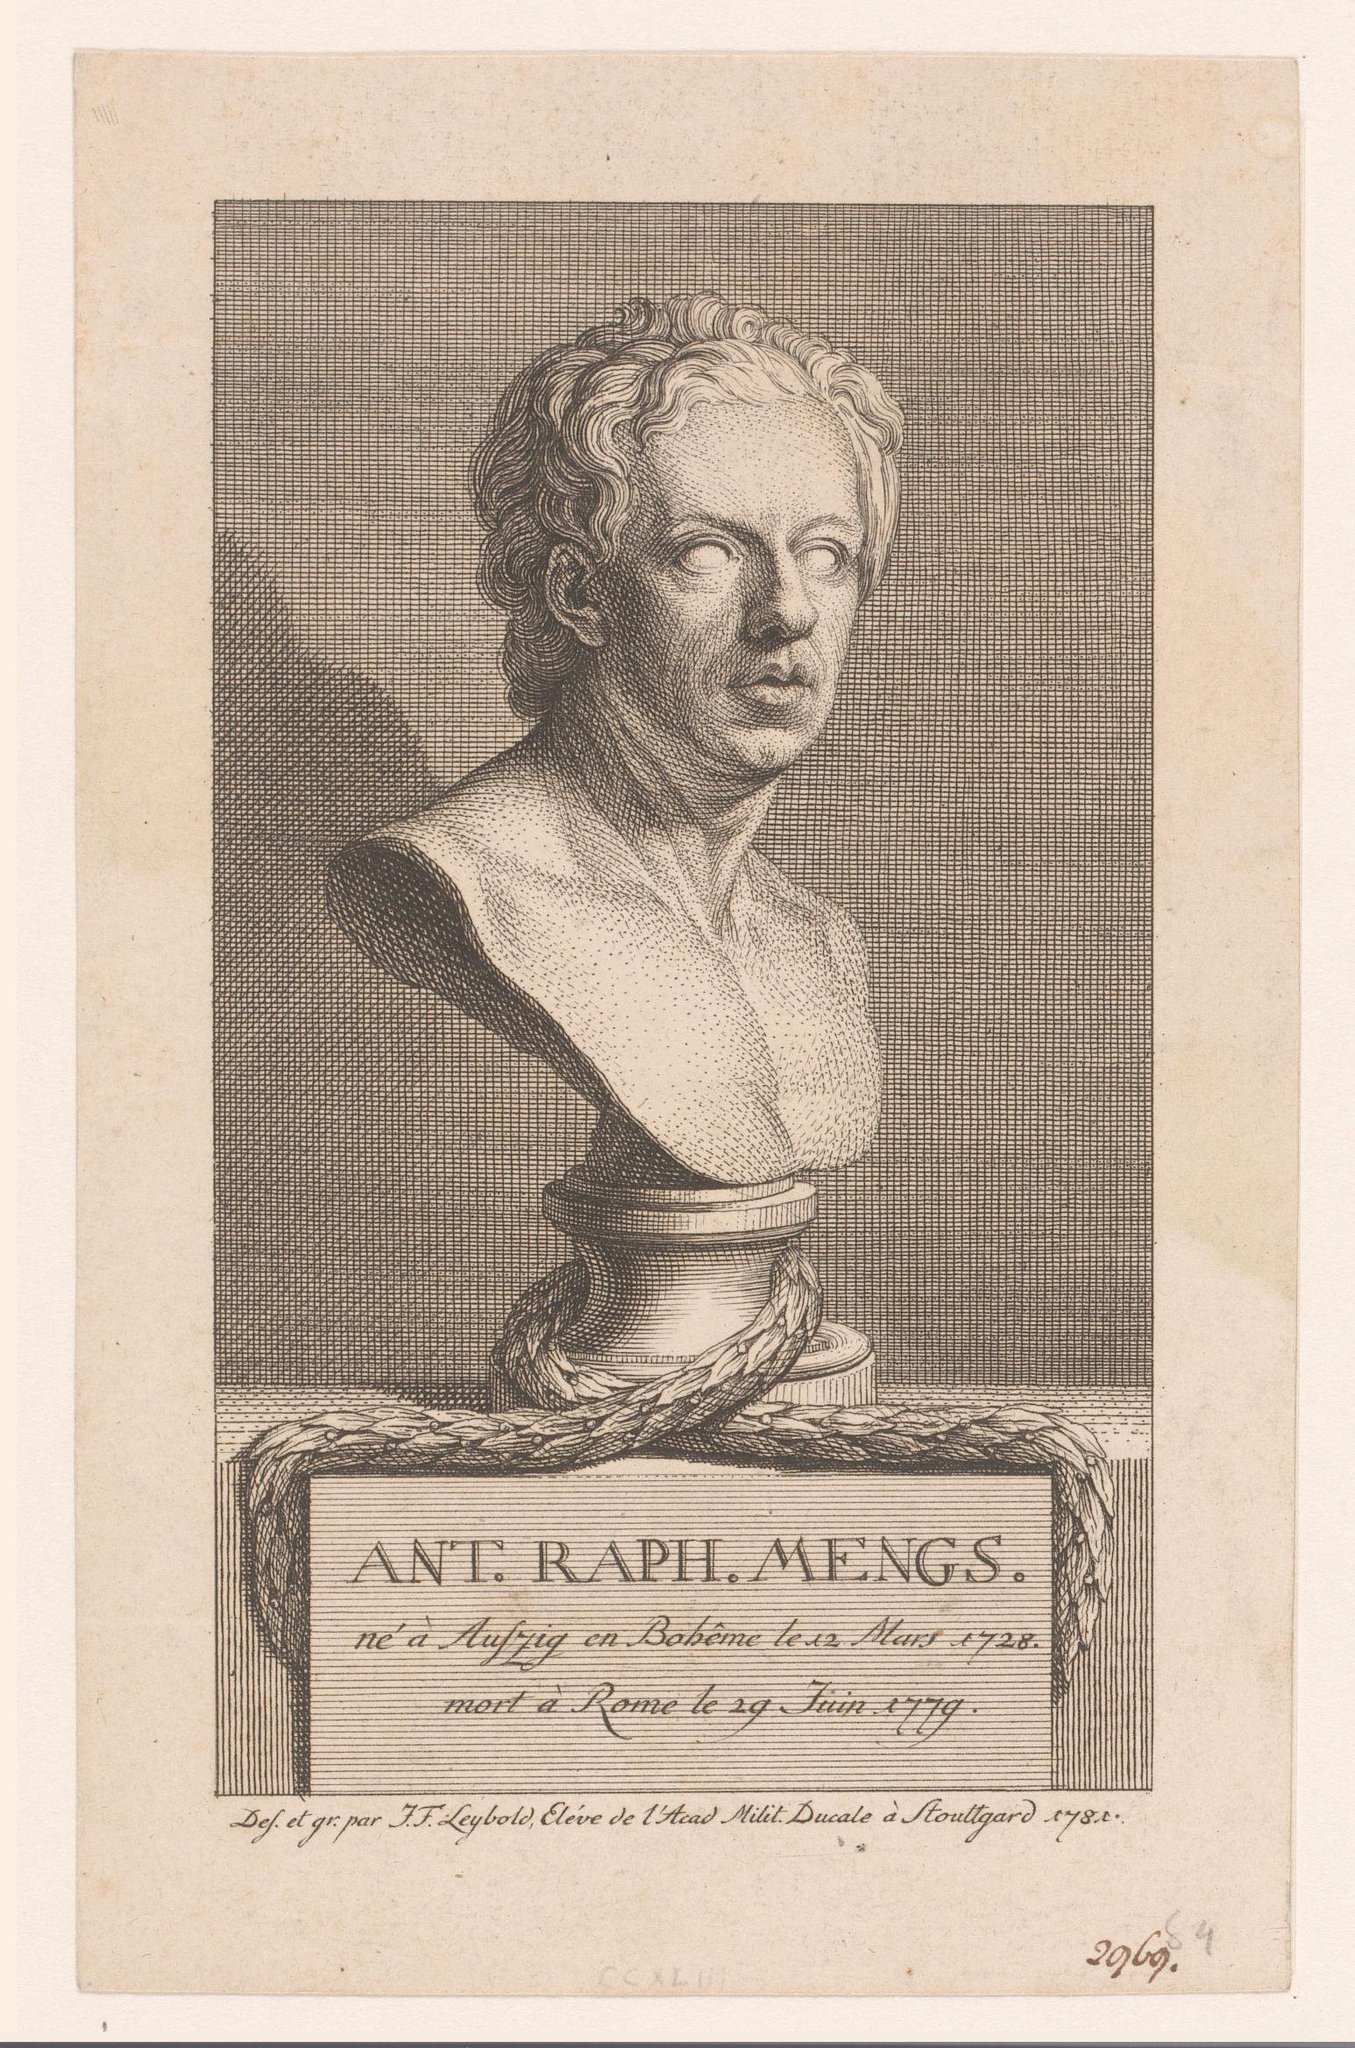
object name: print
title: Portret van Anton Raphael Mengs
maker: johann leypold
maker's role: print maker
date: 1781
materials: paper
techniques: engraving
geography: stuttgart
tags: rome, painter, draughtsman, anton raphael mengs, historical persons, portrait, self-portrait of artist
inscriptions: collector's mark: Lugt 2228